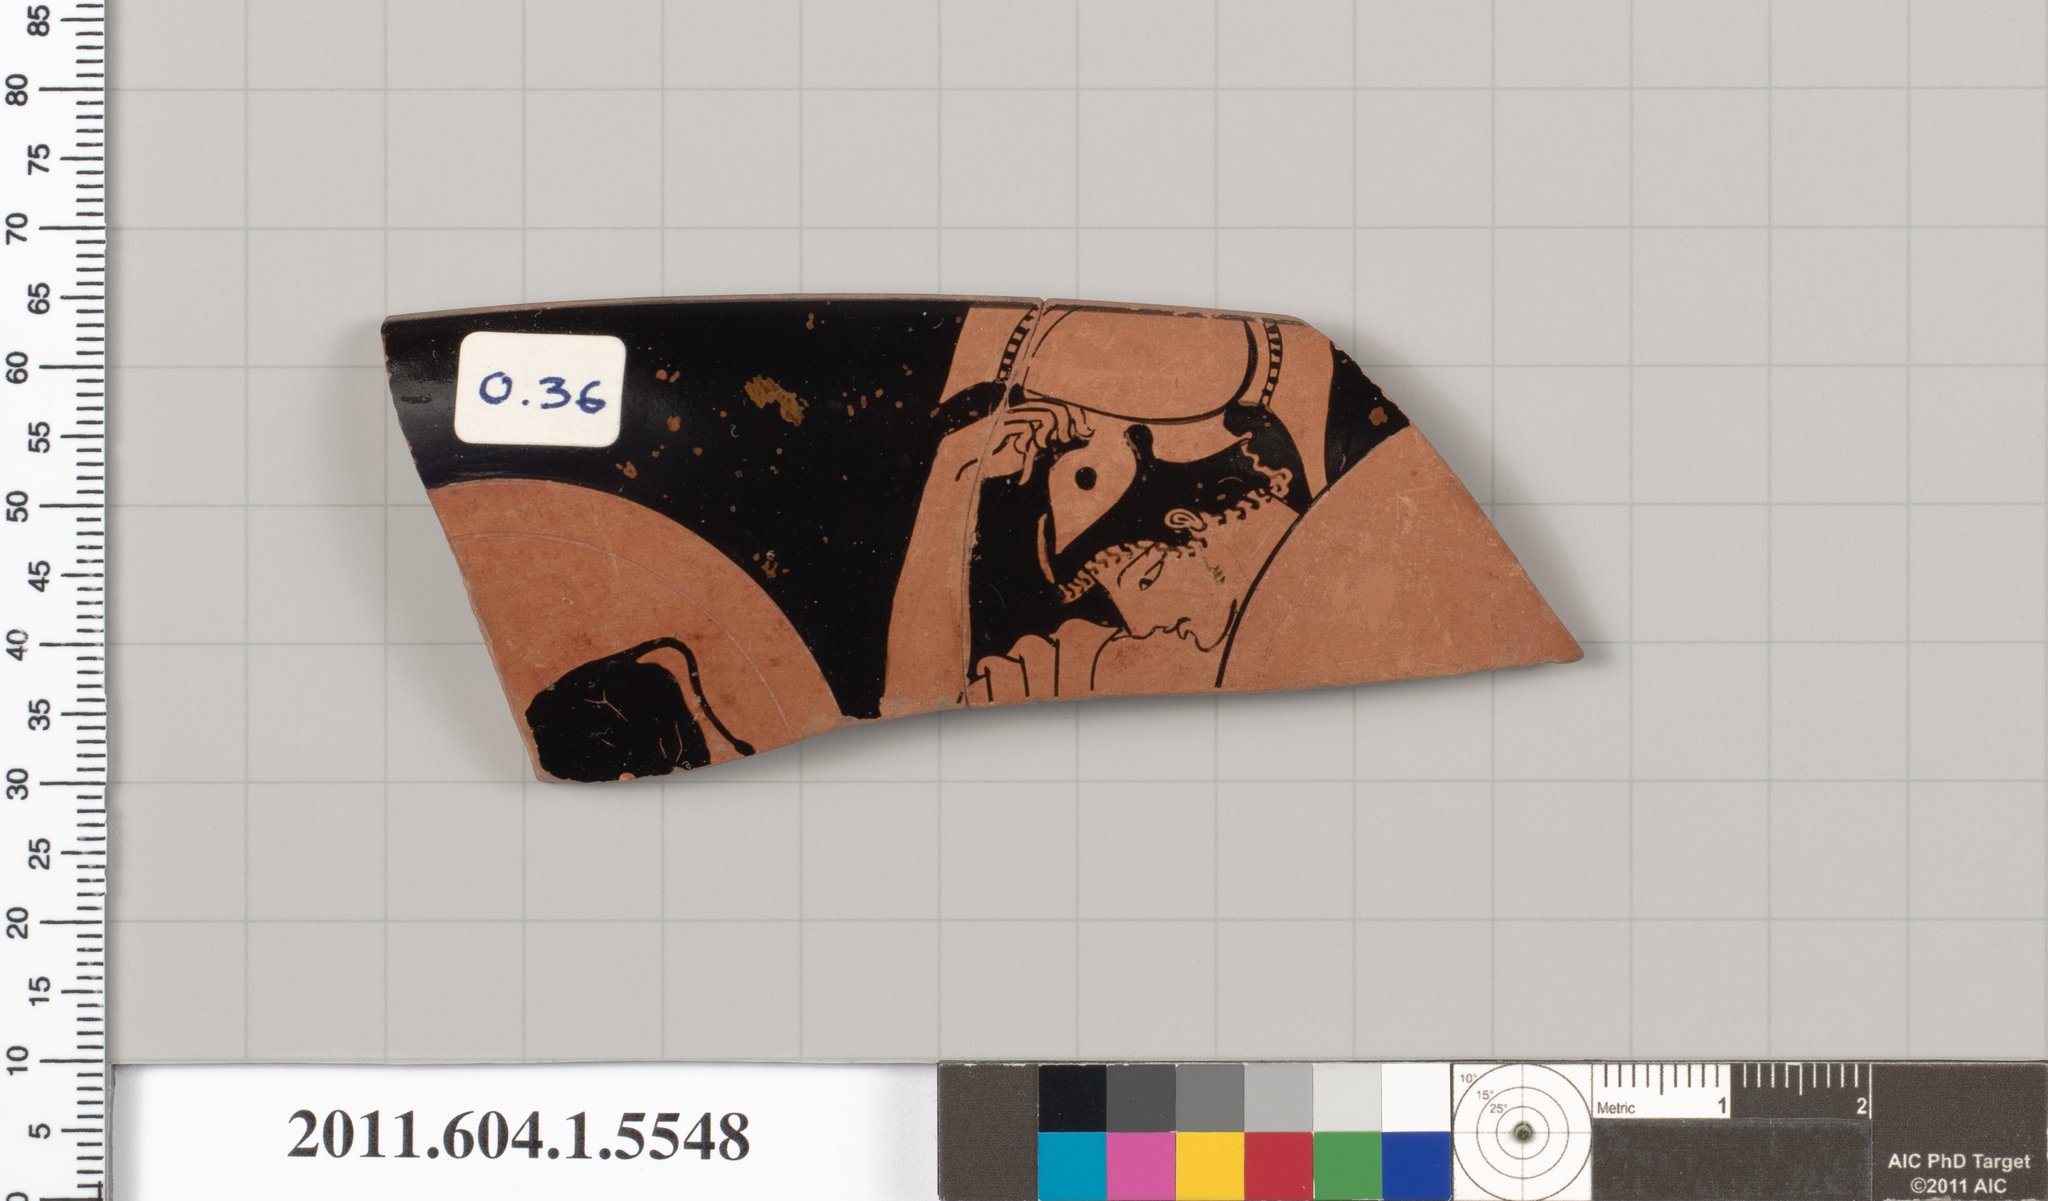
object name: kylix fragment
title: Terracotta rim fragment of a kylix (drinking cup)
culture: greek, attic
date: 500-480 BCE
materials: terracotta